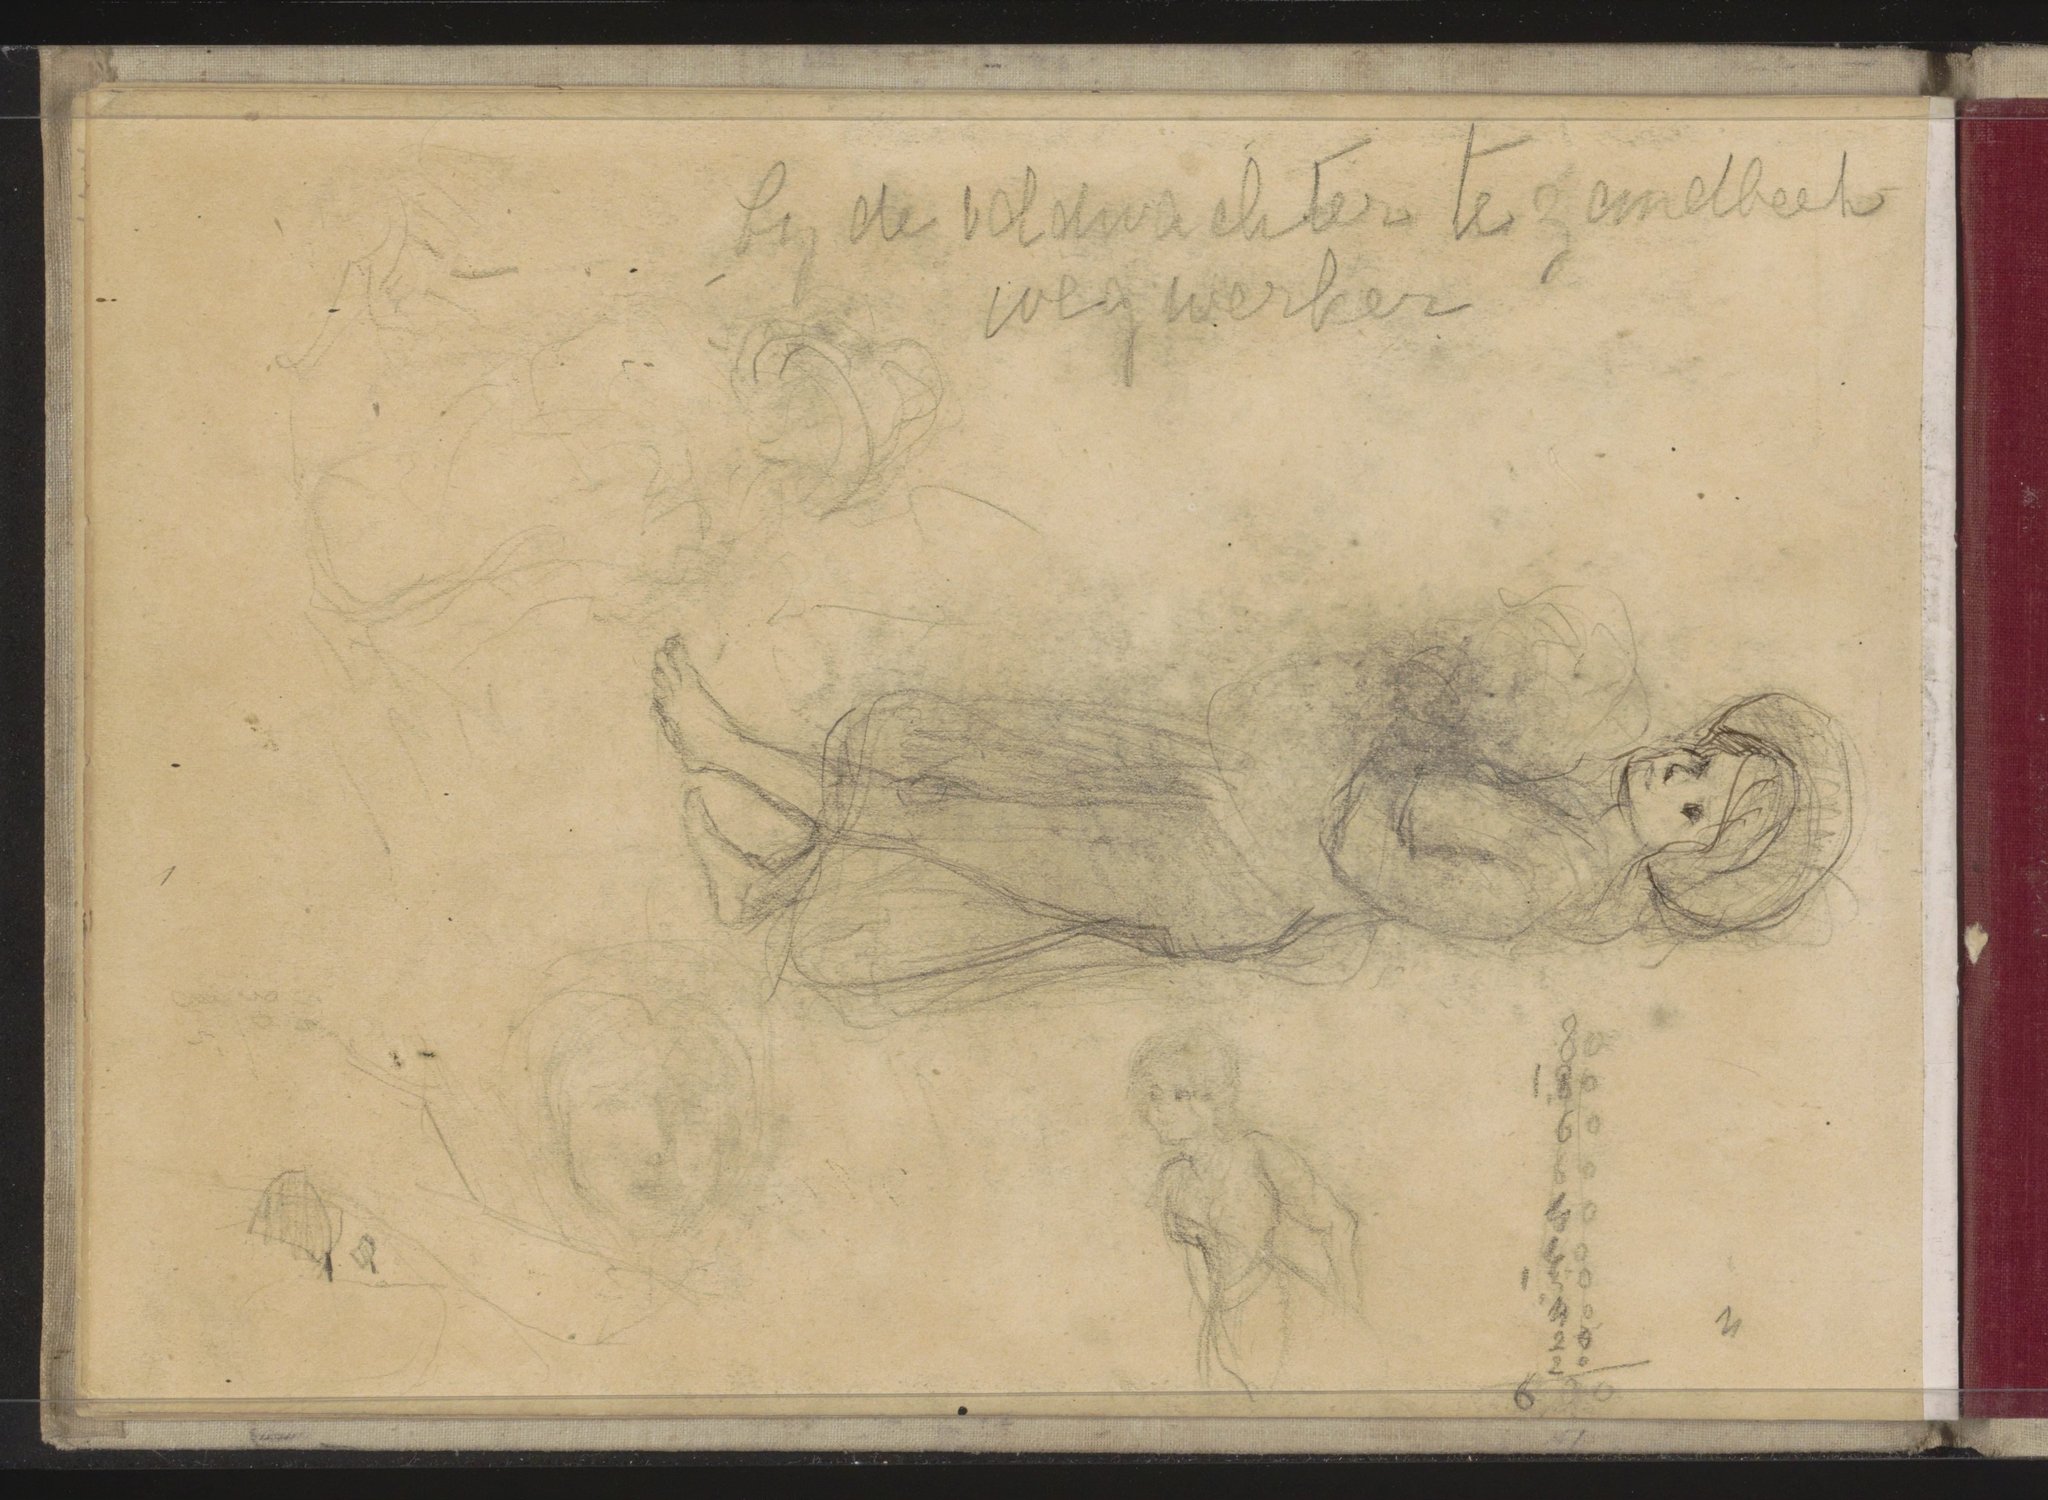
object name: sketchbook leaf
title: Studieblad, onder andere met een staand meisje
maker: jozef israëls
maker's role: draughtsman, painter, print maker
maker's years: 1824-1911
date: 1834-1911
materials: paper, pencil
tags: girl (child between toddler and youth)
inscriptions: annotation: ‘bij de vol[...] achter te zandbeek/ wegwerker’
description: Tevens figuurstudies. Blad 18 verso uit een schetsboek met 18 bladen.